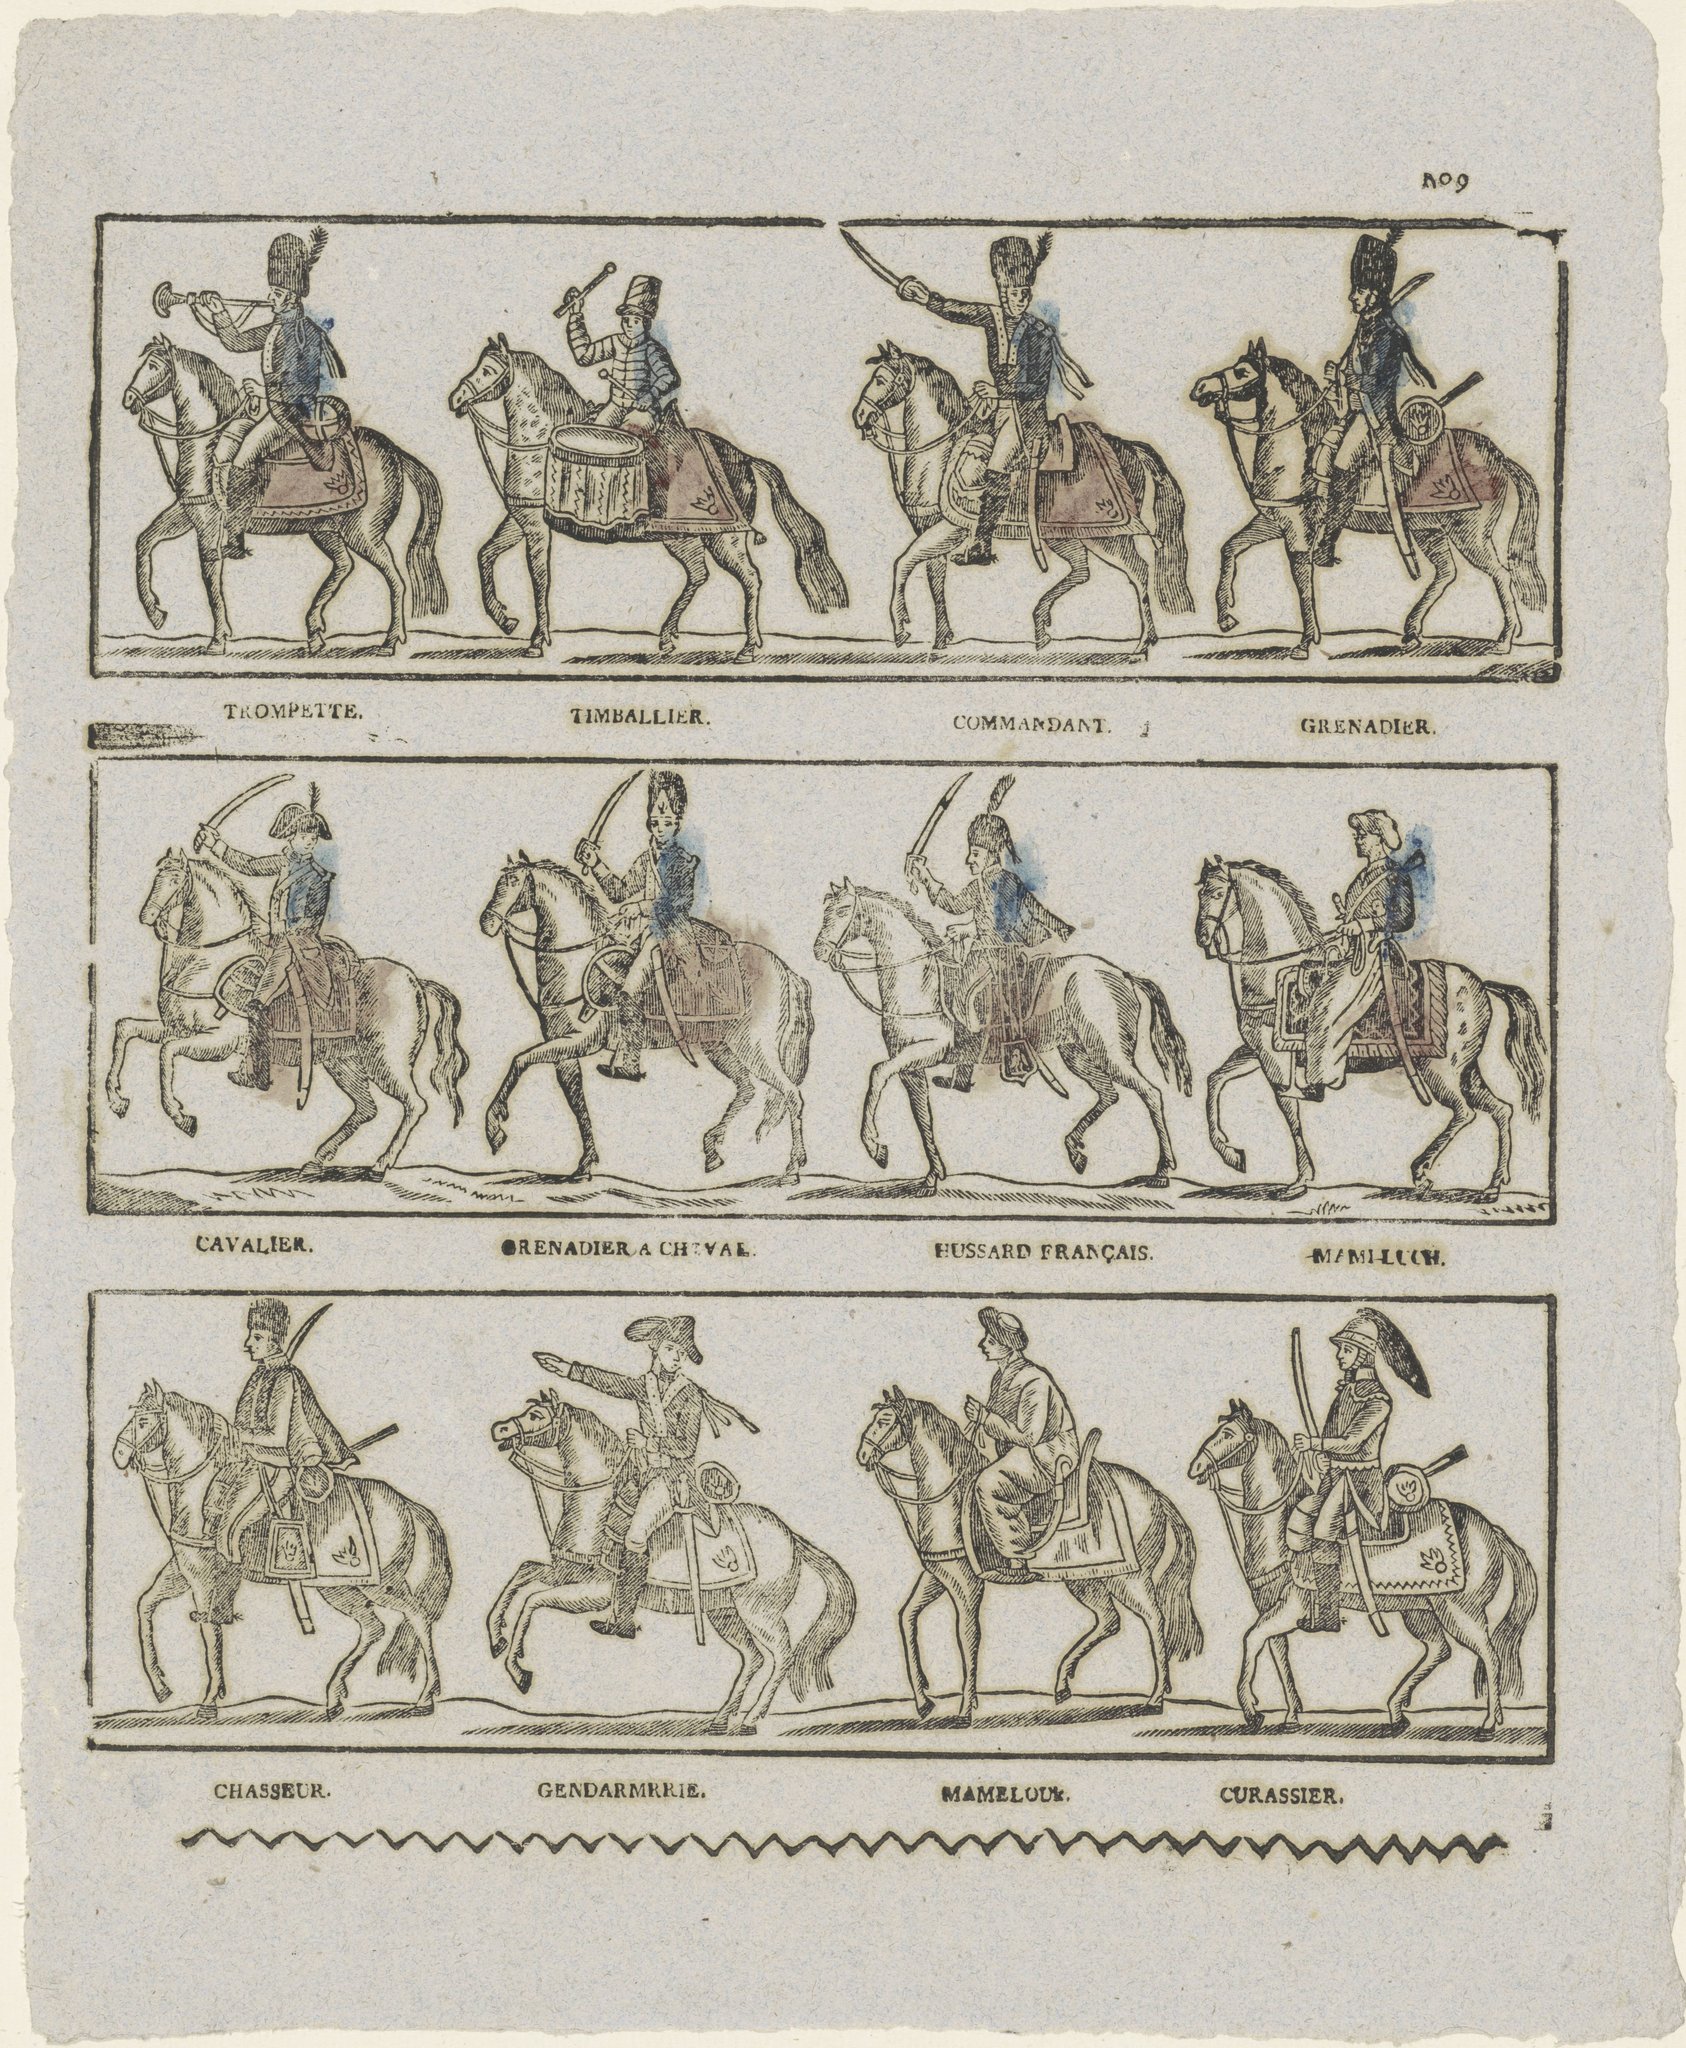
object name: print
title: Militairen te paard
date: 1806-1814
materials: paper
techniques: colour, letterpress printing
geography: europe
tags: warfare; military affairs (+ cavalry, horsemen), the soldier; the soldier's life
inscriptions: collector's mark: Lugt 2760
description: Blad met 3 horizontale rijen met voorstellingen van militairen te paard. Onder elke afbeelding een onderschrift in het Frans. Genummerd rechtsboven: No. 9.